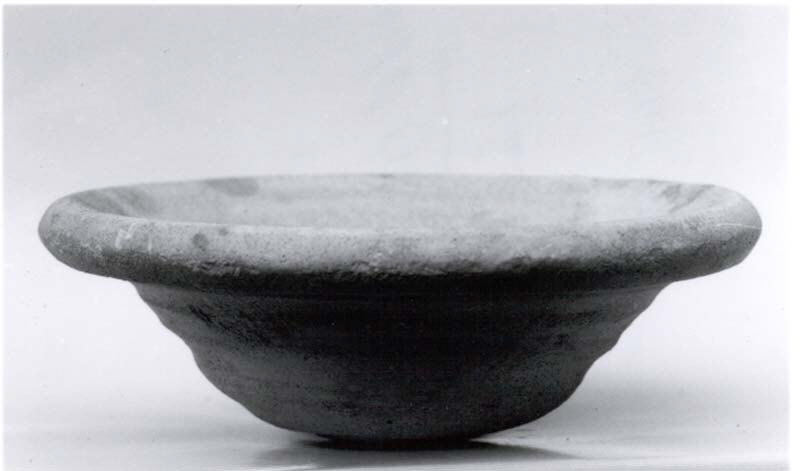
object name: bowl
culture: sasanian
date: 201-700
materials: ceramic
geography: mesopotamia